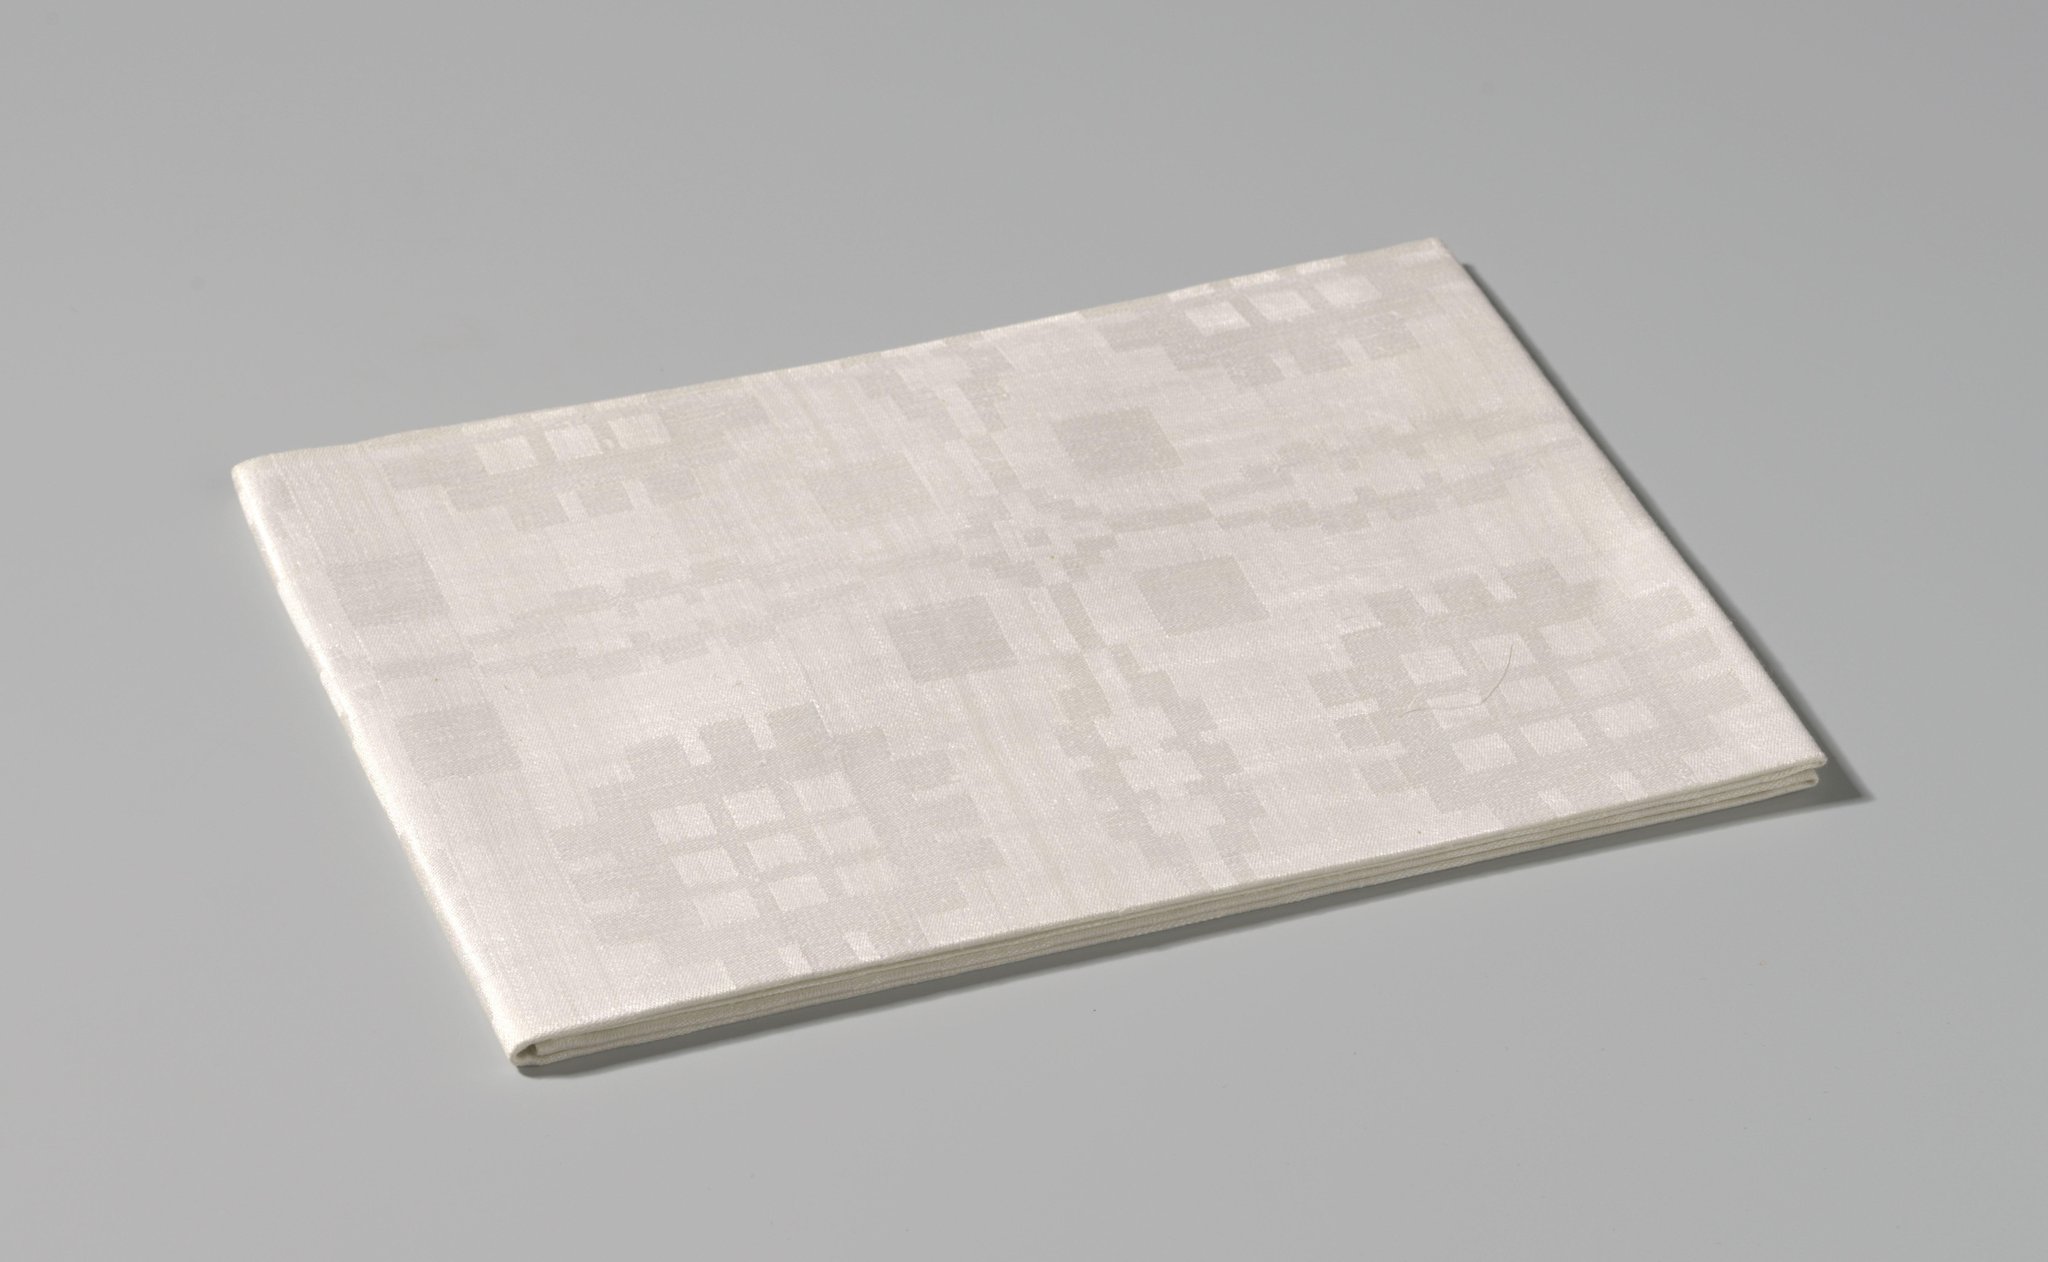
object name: napkin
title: Servet van linnen met pellenpatroon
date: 1730-1786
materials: linen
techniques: peeled fabric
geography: northern netherlands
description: wit linnen servet met pellen patroon, merk kroon IAVG 12